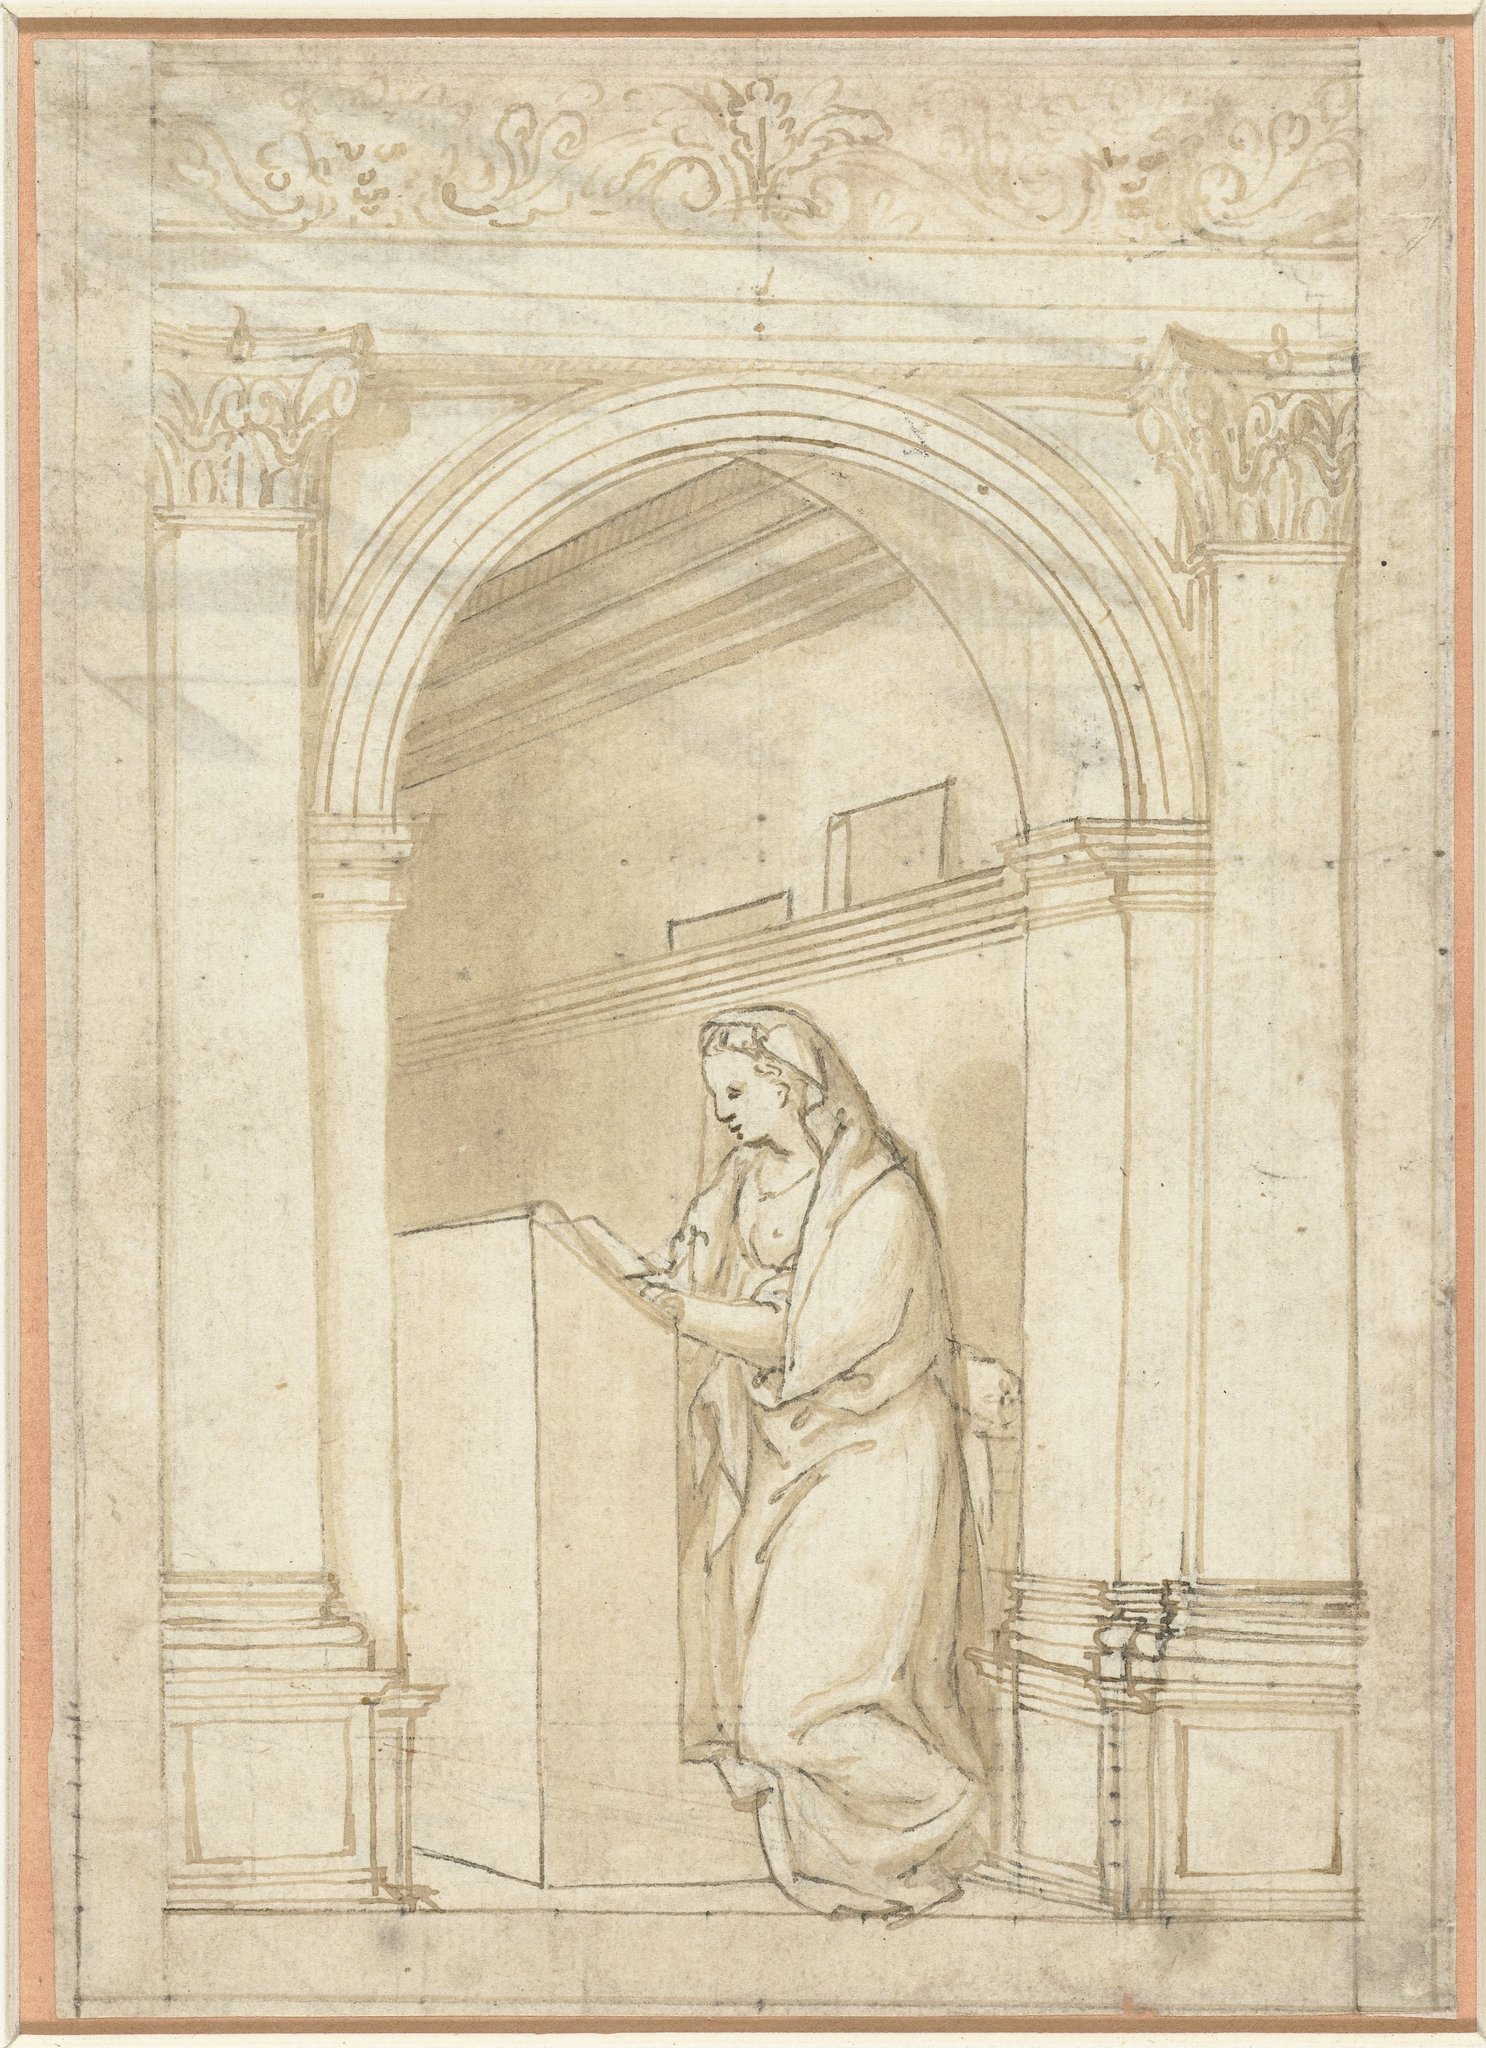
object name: drawing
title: Knielende Maria in een architectuur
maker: Anonymous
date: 1500-1520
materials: chalk, ink, paper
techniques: brush, pen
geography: northern italy